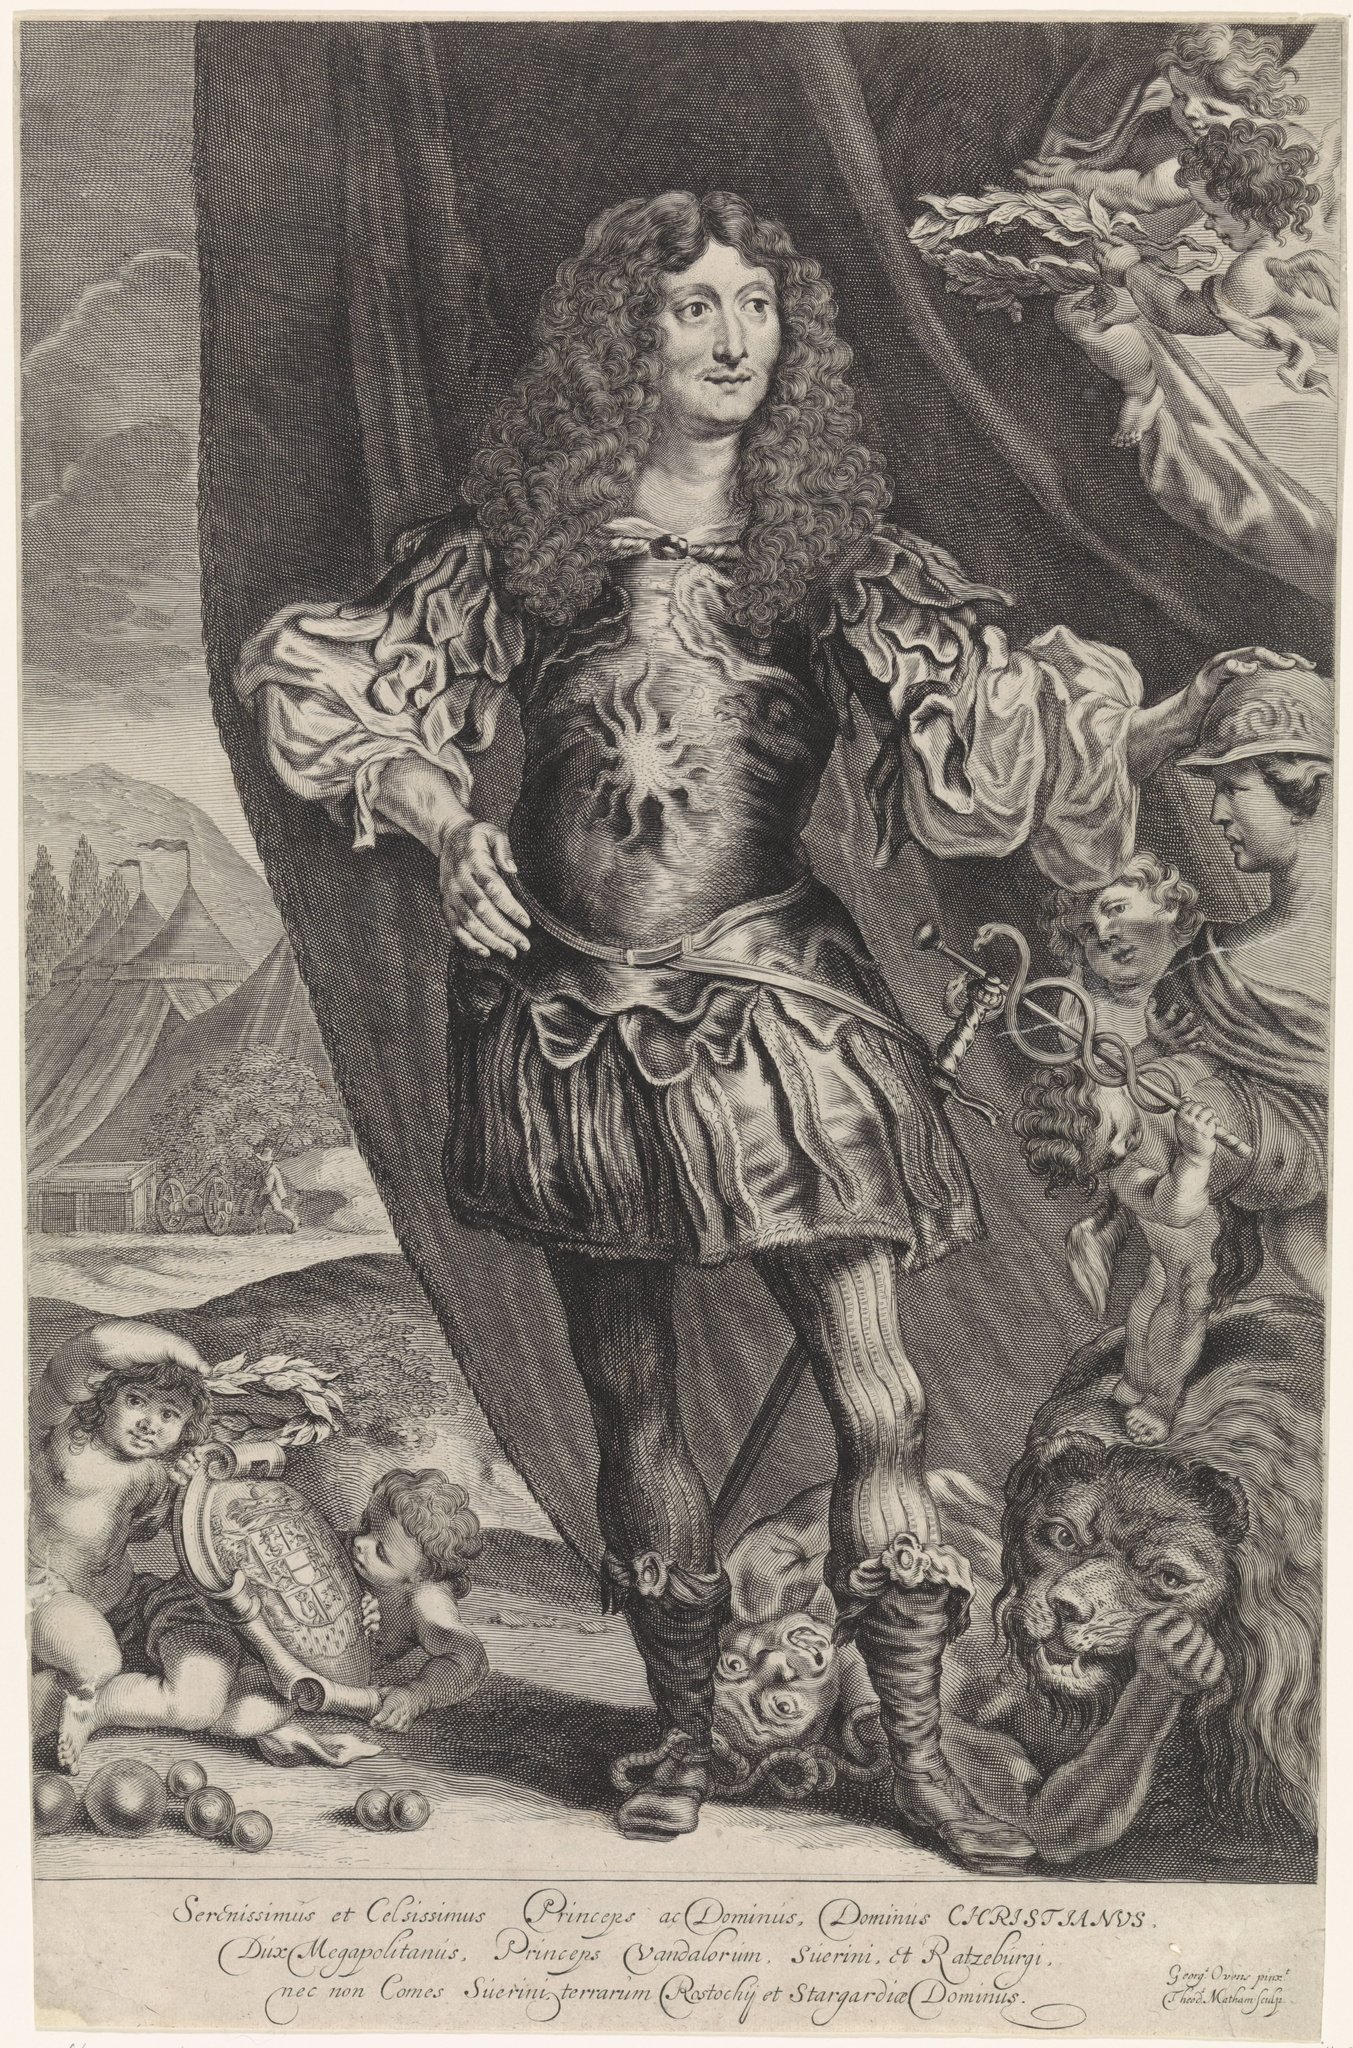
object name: print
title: Portret van Christiaan Lodewijk I van Mecklenburg-Schwerin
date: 1633-1676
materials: paper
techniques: engraving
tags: the hague, (military) camp with tents (+ weapons), crowning with laurel, specific aspects, allegorical aspects of mercury; mercury as patron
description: Portret ten voeten uit van Christiaan Lodewijk I van Mecklenburg-Schwerin. Zijn hand rust op de hoed van Mercurius, een putto houdt diens caduceus vast. Aan zijn voeten een leeuw en op de grond een figuur met slangen als haar. Links twee kinderen met een wapenschild, voor hem op de grond liggen kanonskogels. Op de achtergrond een legerkamp en een figuur bij een kanon. Rechtsboven twee putti met een lauwerkrans.